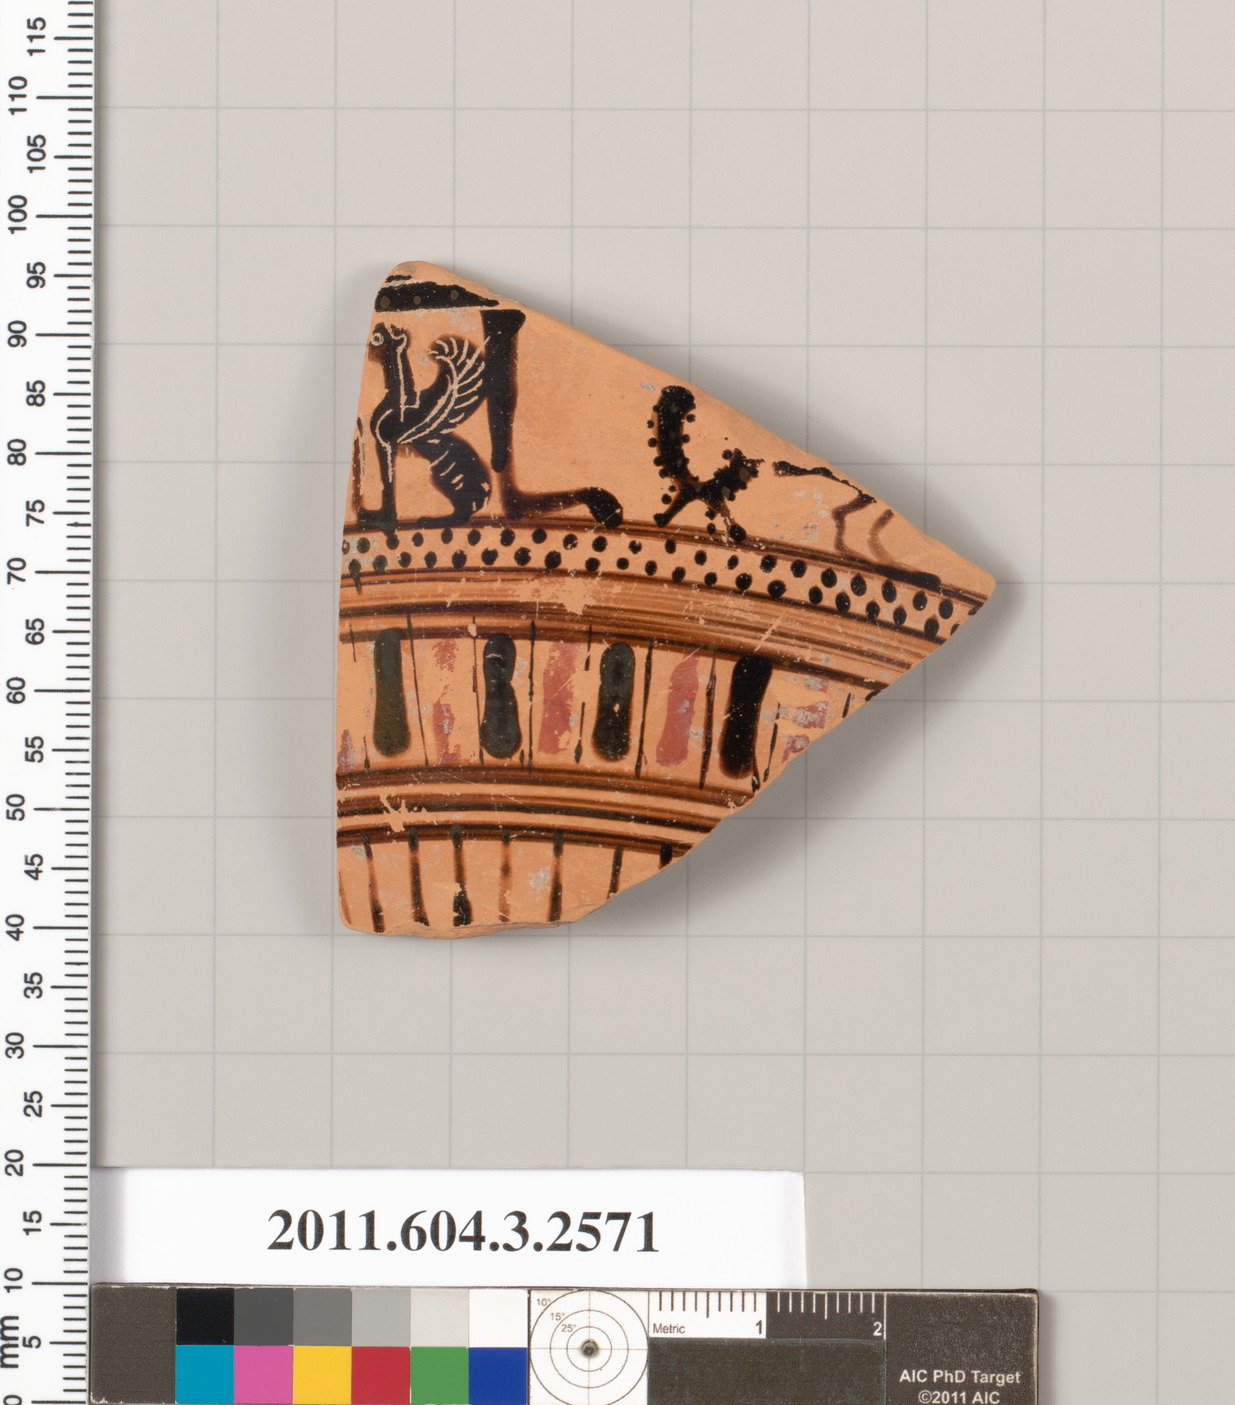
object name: amphora fragment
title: Terracotta fragment of an amphora (jar)?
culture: greek, attic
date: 550-526 BCE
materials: terracotta